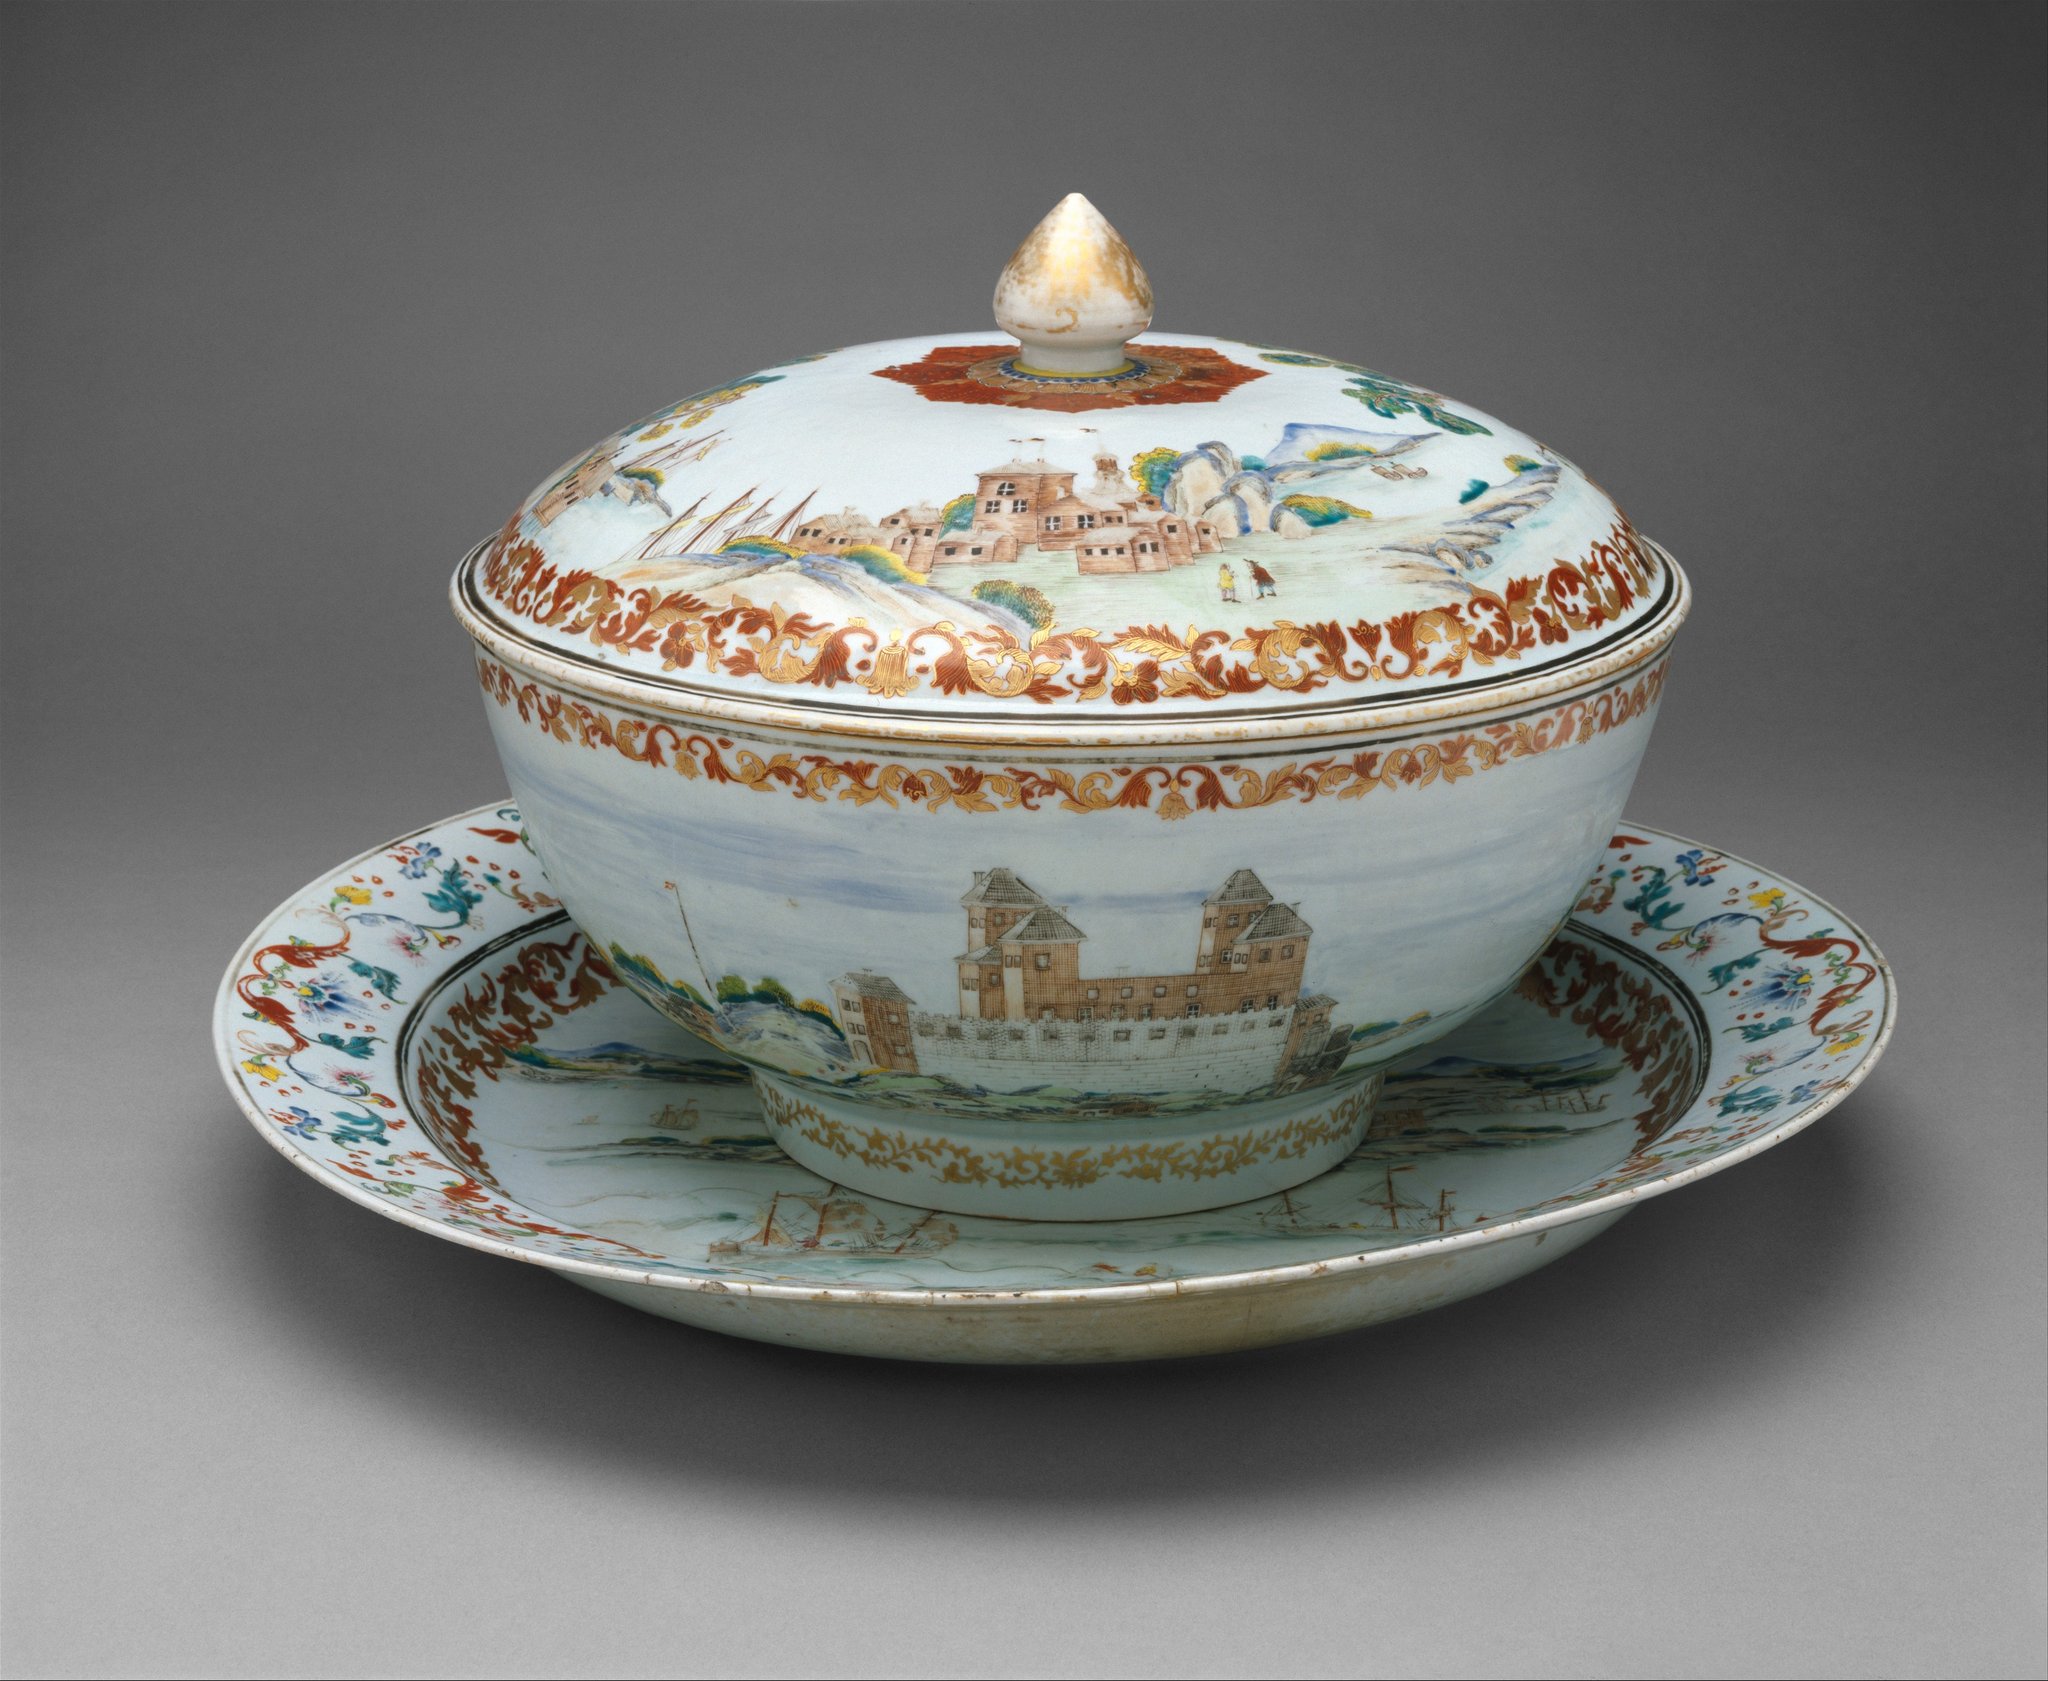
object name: punch bowl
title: Covered Punch Bowl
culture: chinese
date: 1745-1755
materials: porcelain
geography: china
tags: buildings